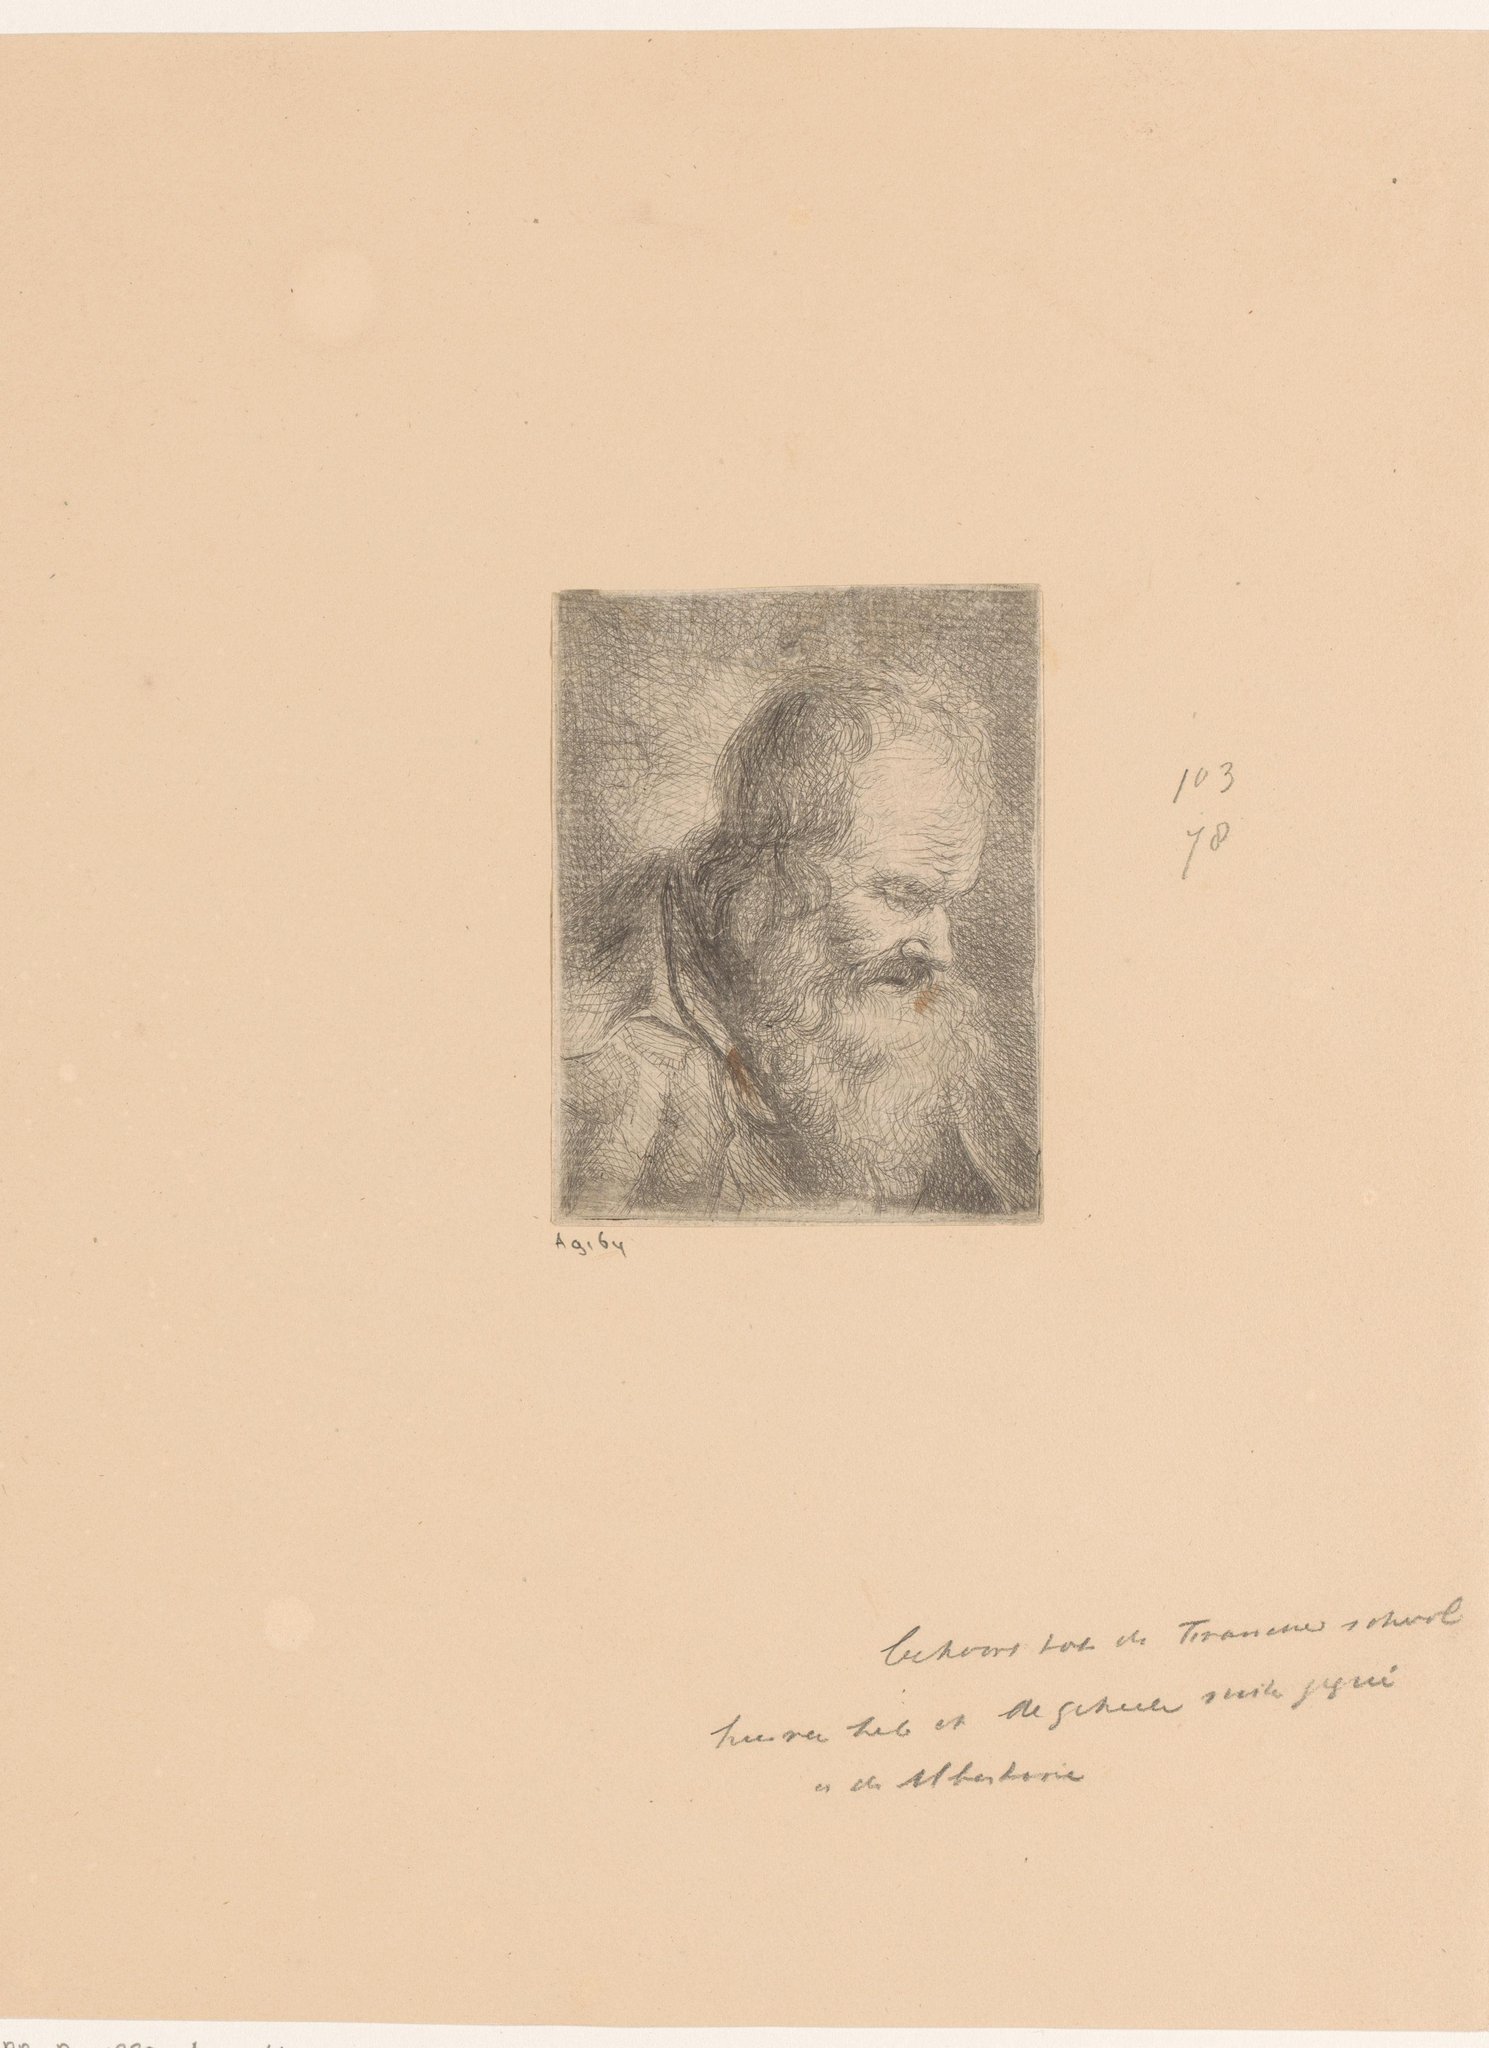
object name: print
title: Buste van een oude man met baard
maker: Anonymous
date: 1750-1850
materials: paper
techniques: etching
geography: france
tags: old man, beard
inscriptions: collector's mark: Lugt 2228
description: Buste van een oude man met baard, in profiel naar links, het hoofd naar beneden gewend.